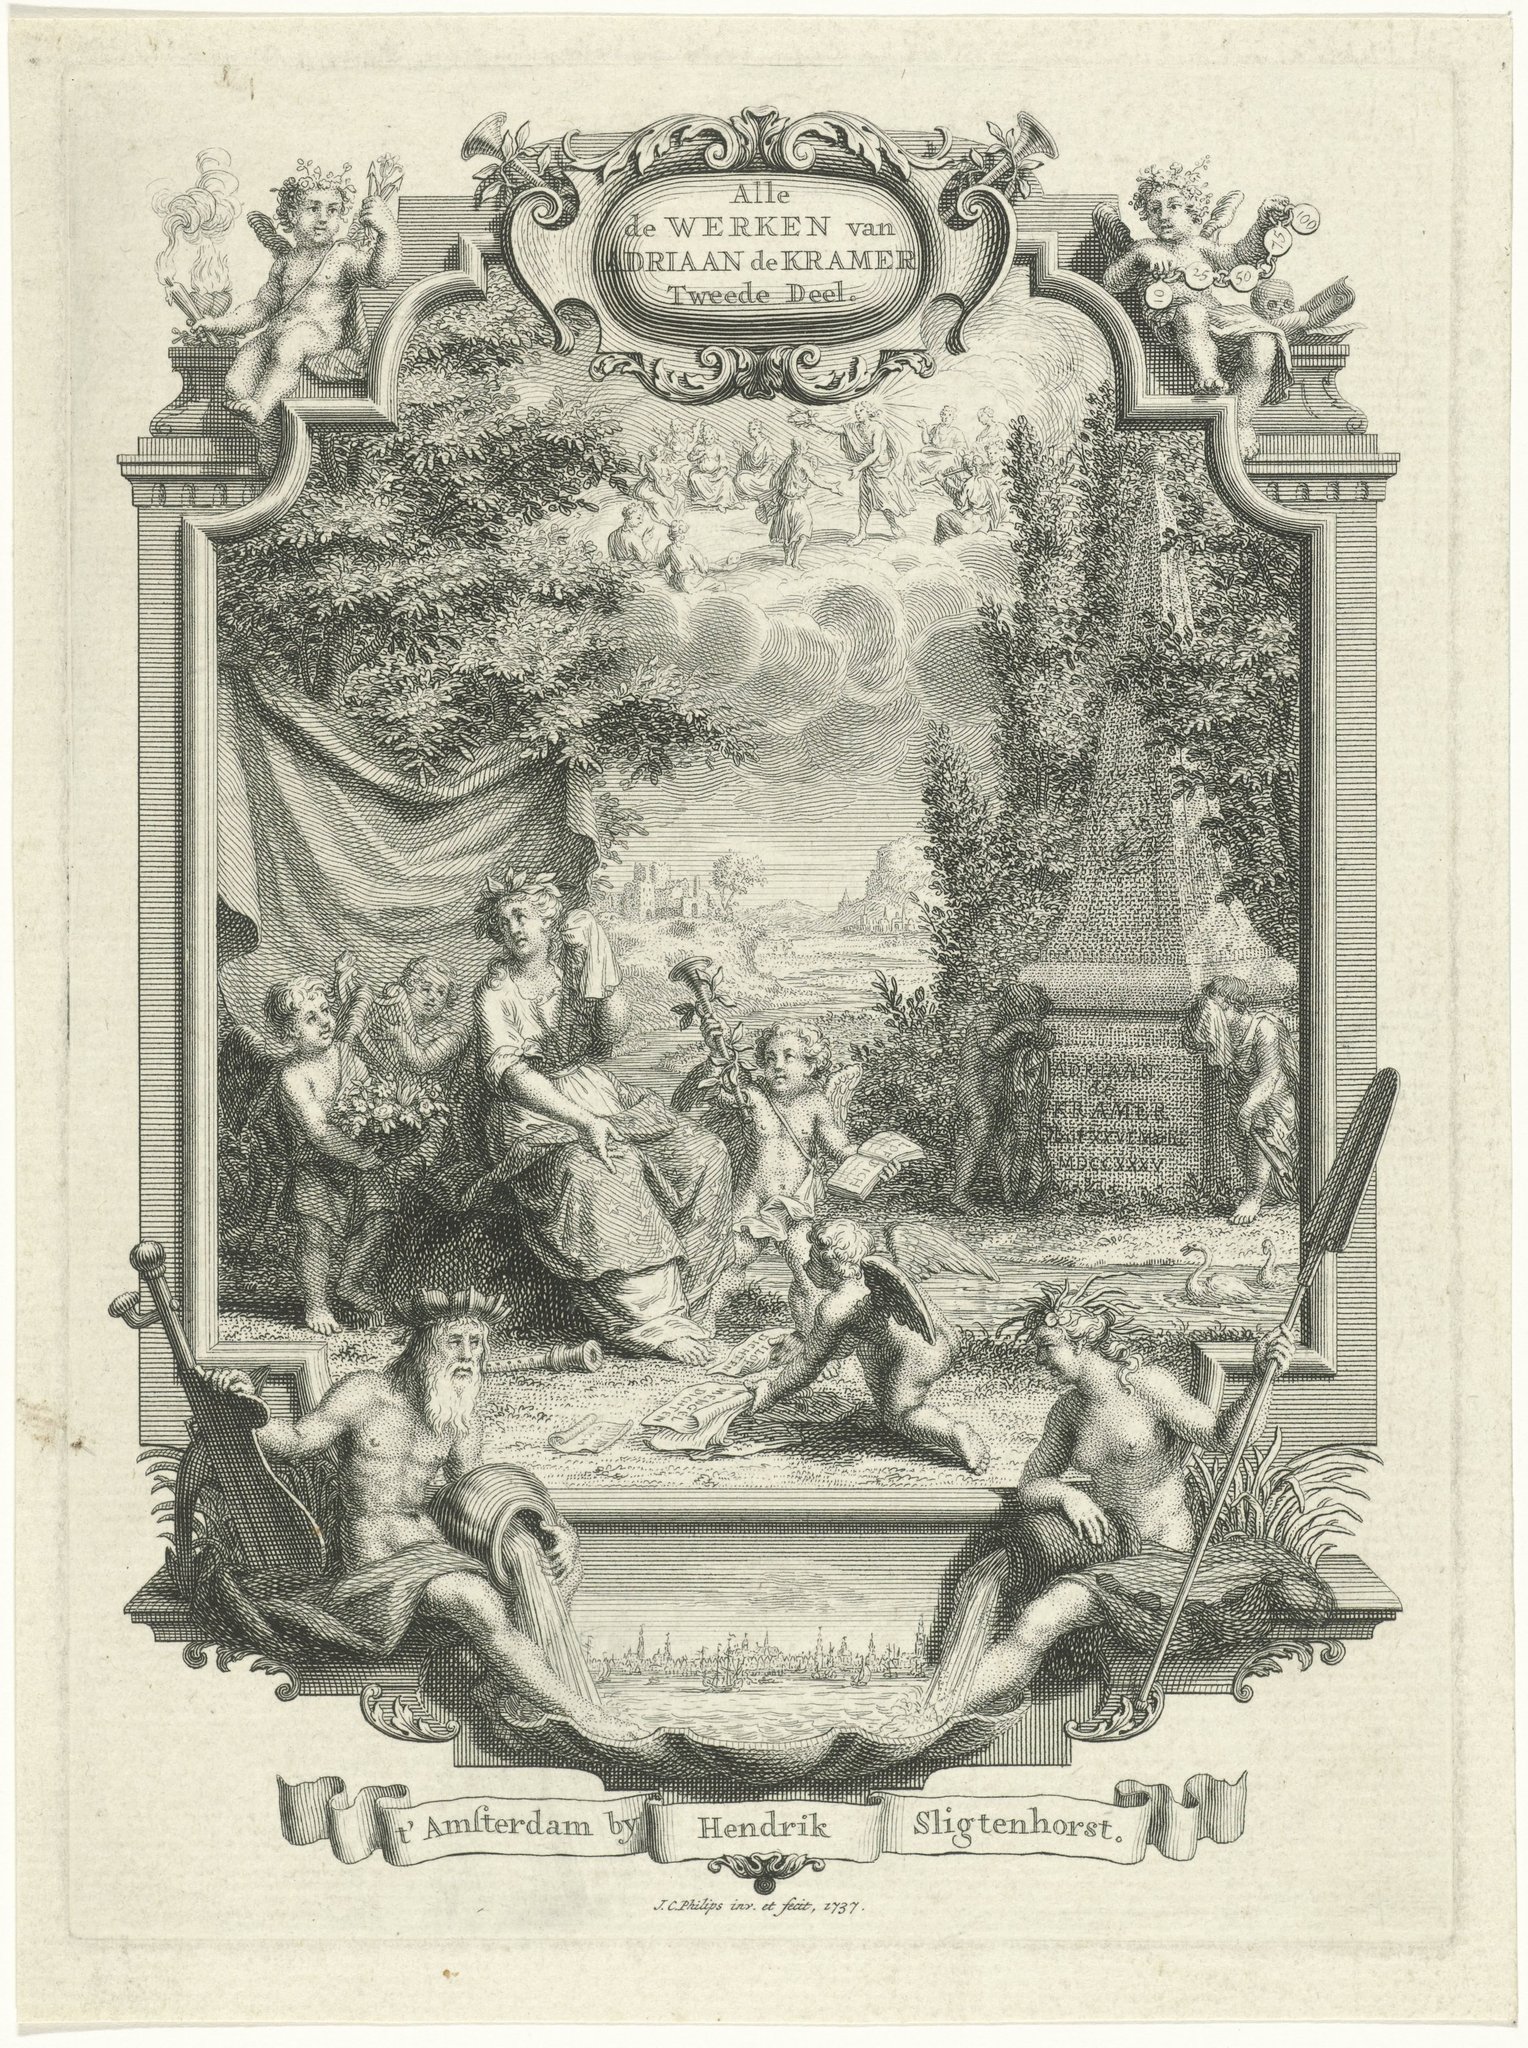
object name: titelblad, titelpagina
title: Poëzie treurt om de dood van Adriaan de Kramer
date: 1737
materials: paper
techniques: engraving, etching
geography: amsterdam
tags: amsterdam, river-gods, symbolic representations, allegories and emblems ~ poetry; 'poesia' (ripa), the muses acting together (as group), crowning with laurel, grave, tomb and other grave-forms and grave-markers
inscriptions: collector's mark: Lugt 2228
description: Poëzie treurt om de dood van de schrijver Adriaan de Kramer. Ze wordt vergezeld door putti met attributen die de kunsten symboliseren. Op de achtergrond het grafmonument met het portret van de schrijver. In de hemel wordt hij gelauwerd, omringd door muzen. In de omlijsting van de cartouche een gezicht op Amsterdam, geflankeerd door twee riviergoden. Op de bovenhoeken putti met Vanitas symbolen.